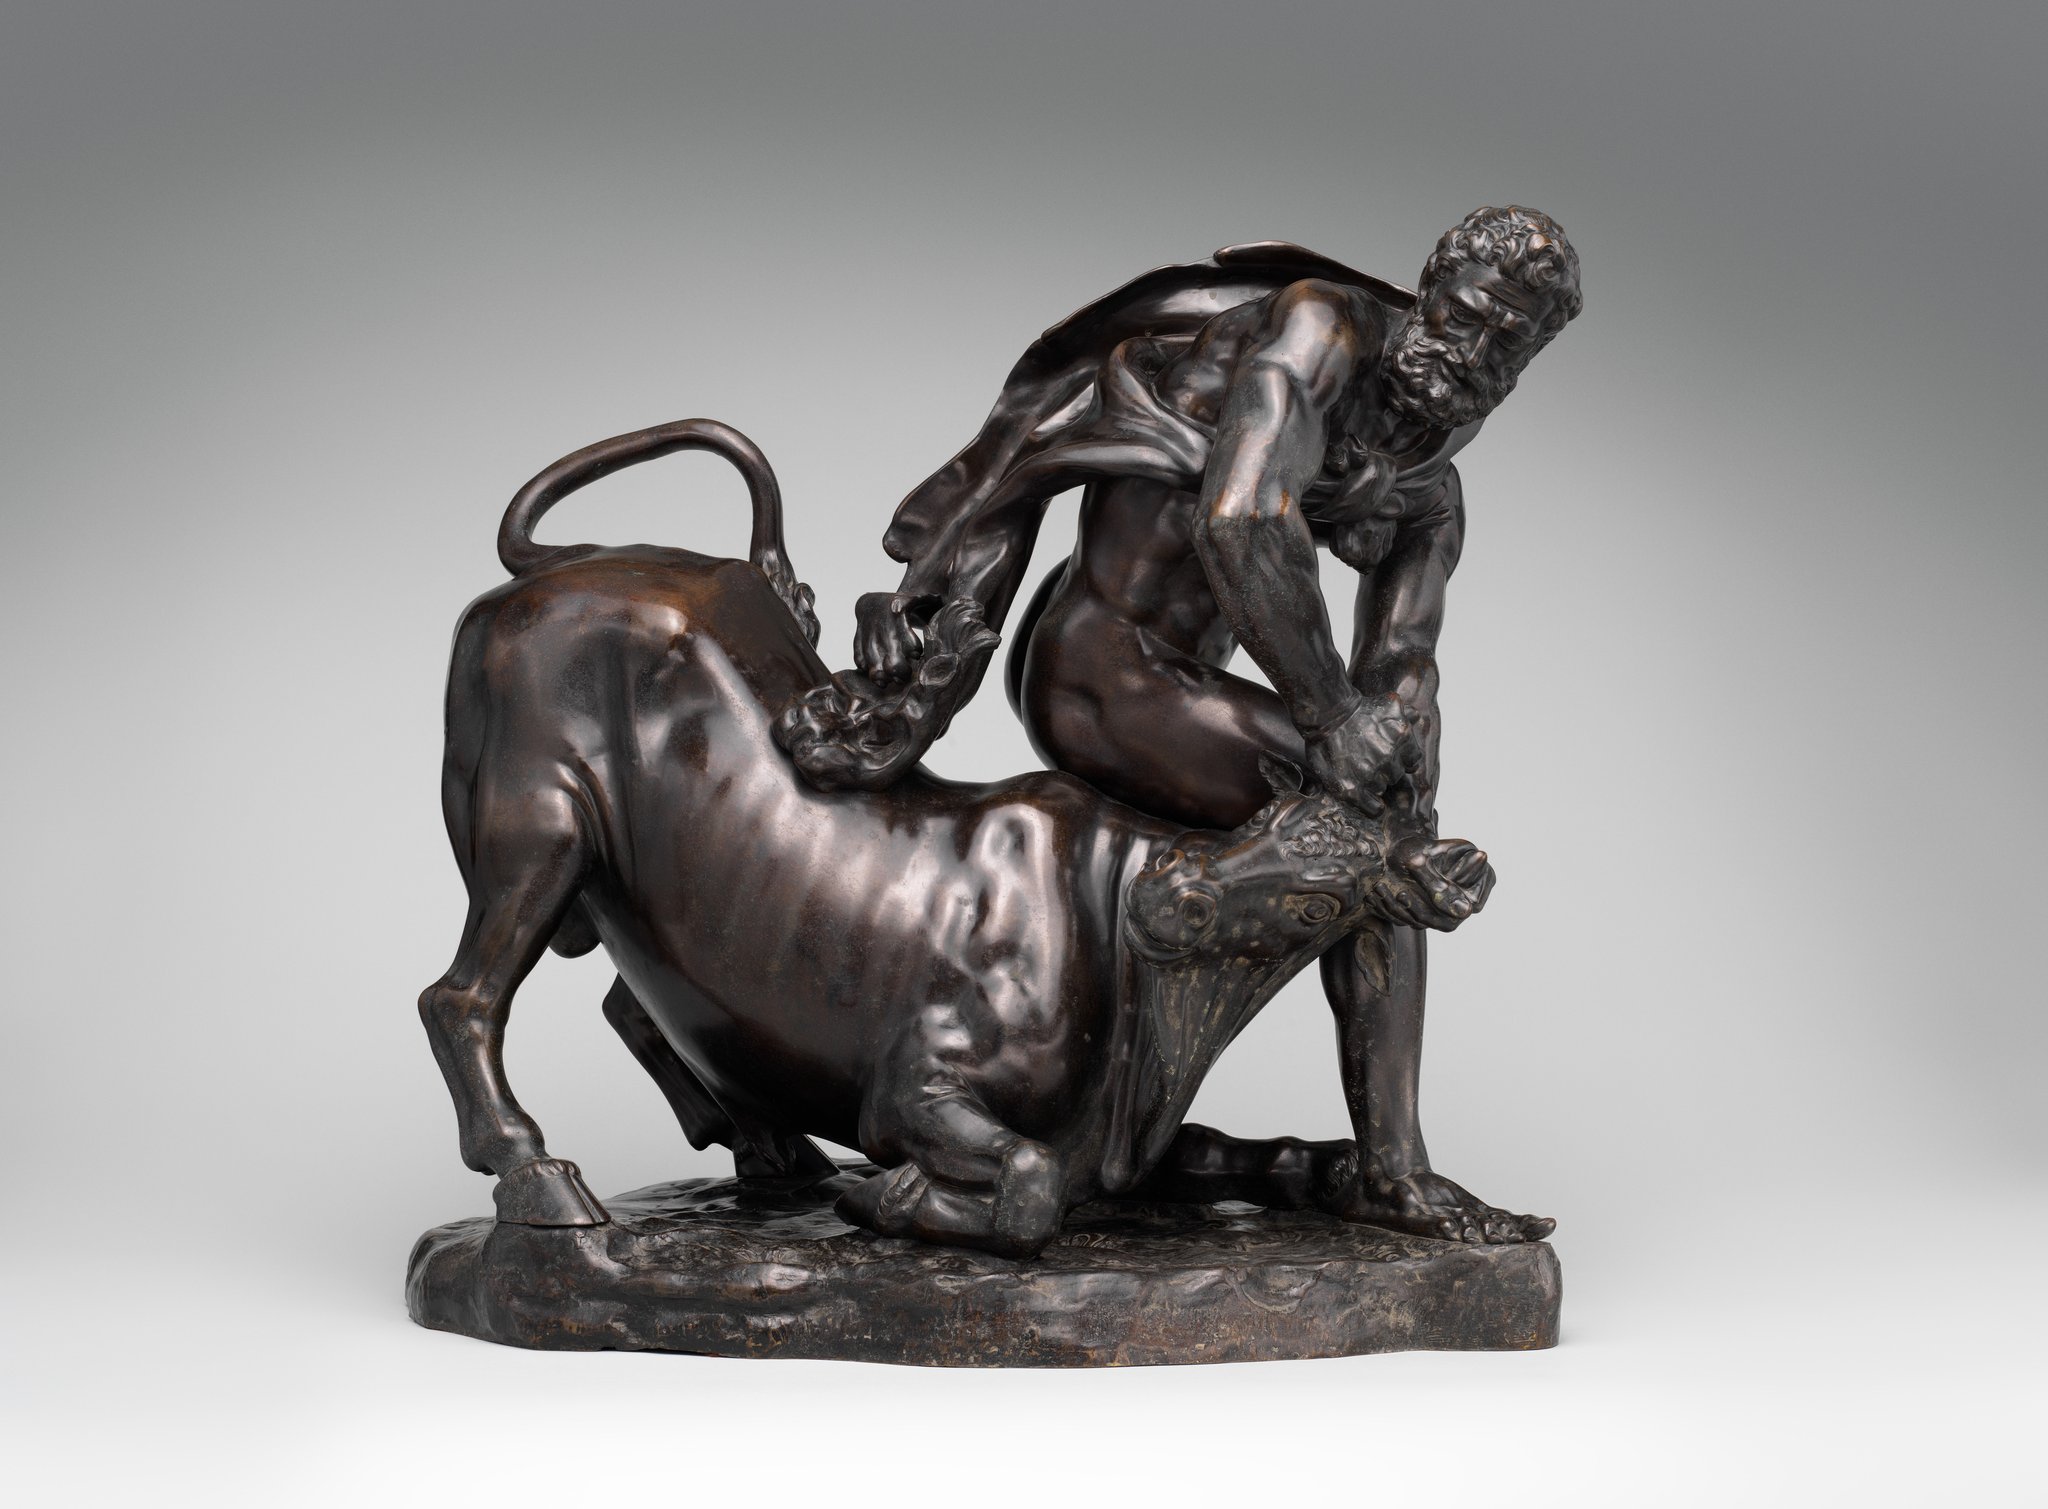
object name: statuette group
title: Hercules and the Cretan Bull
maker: giambologna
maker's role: artist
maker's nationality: netherlandish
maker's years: 1529-1608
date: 1601-1633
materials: bronze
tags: hercules,bulls